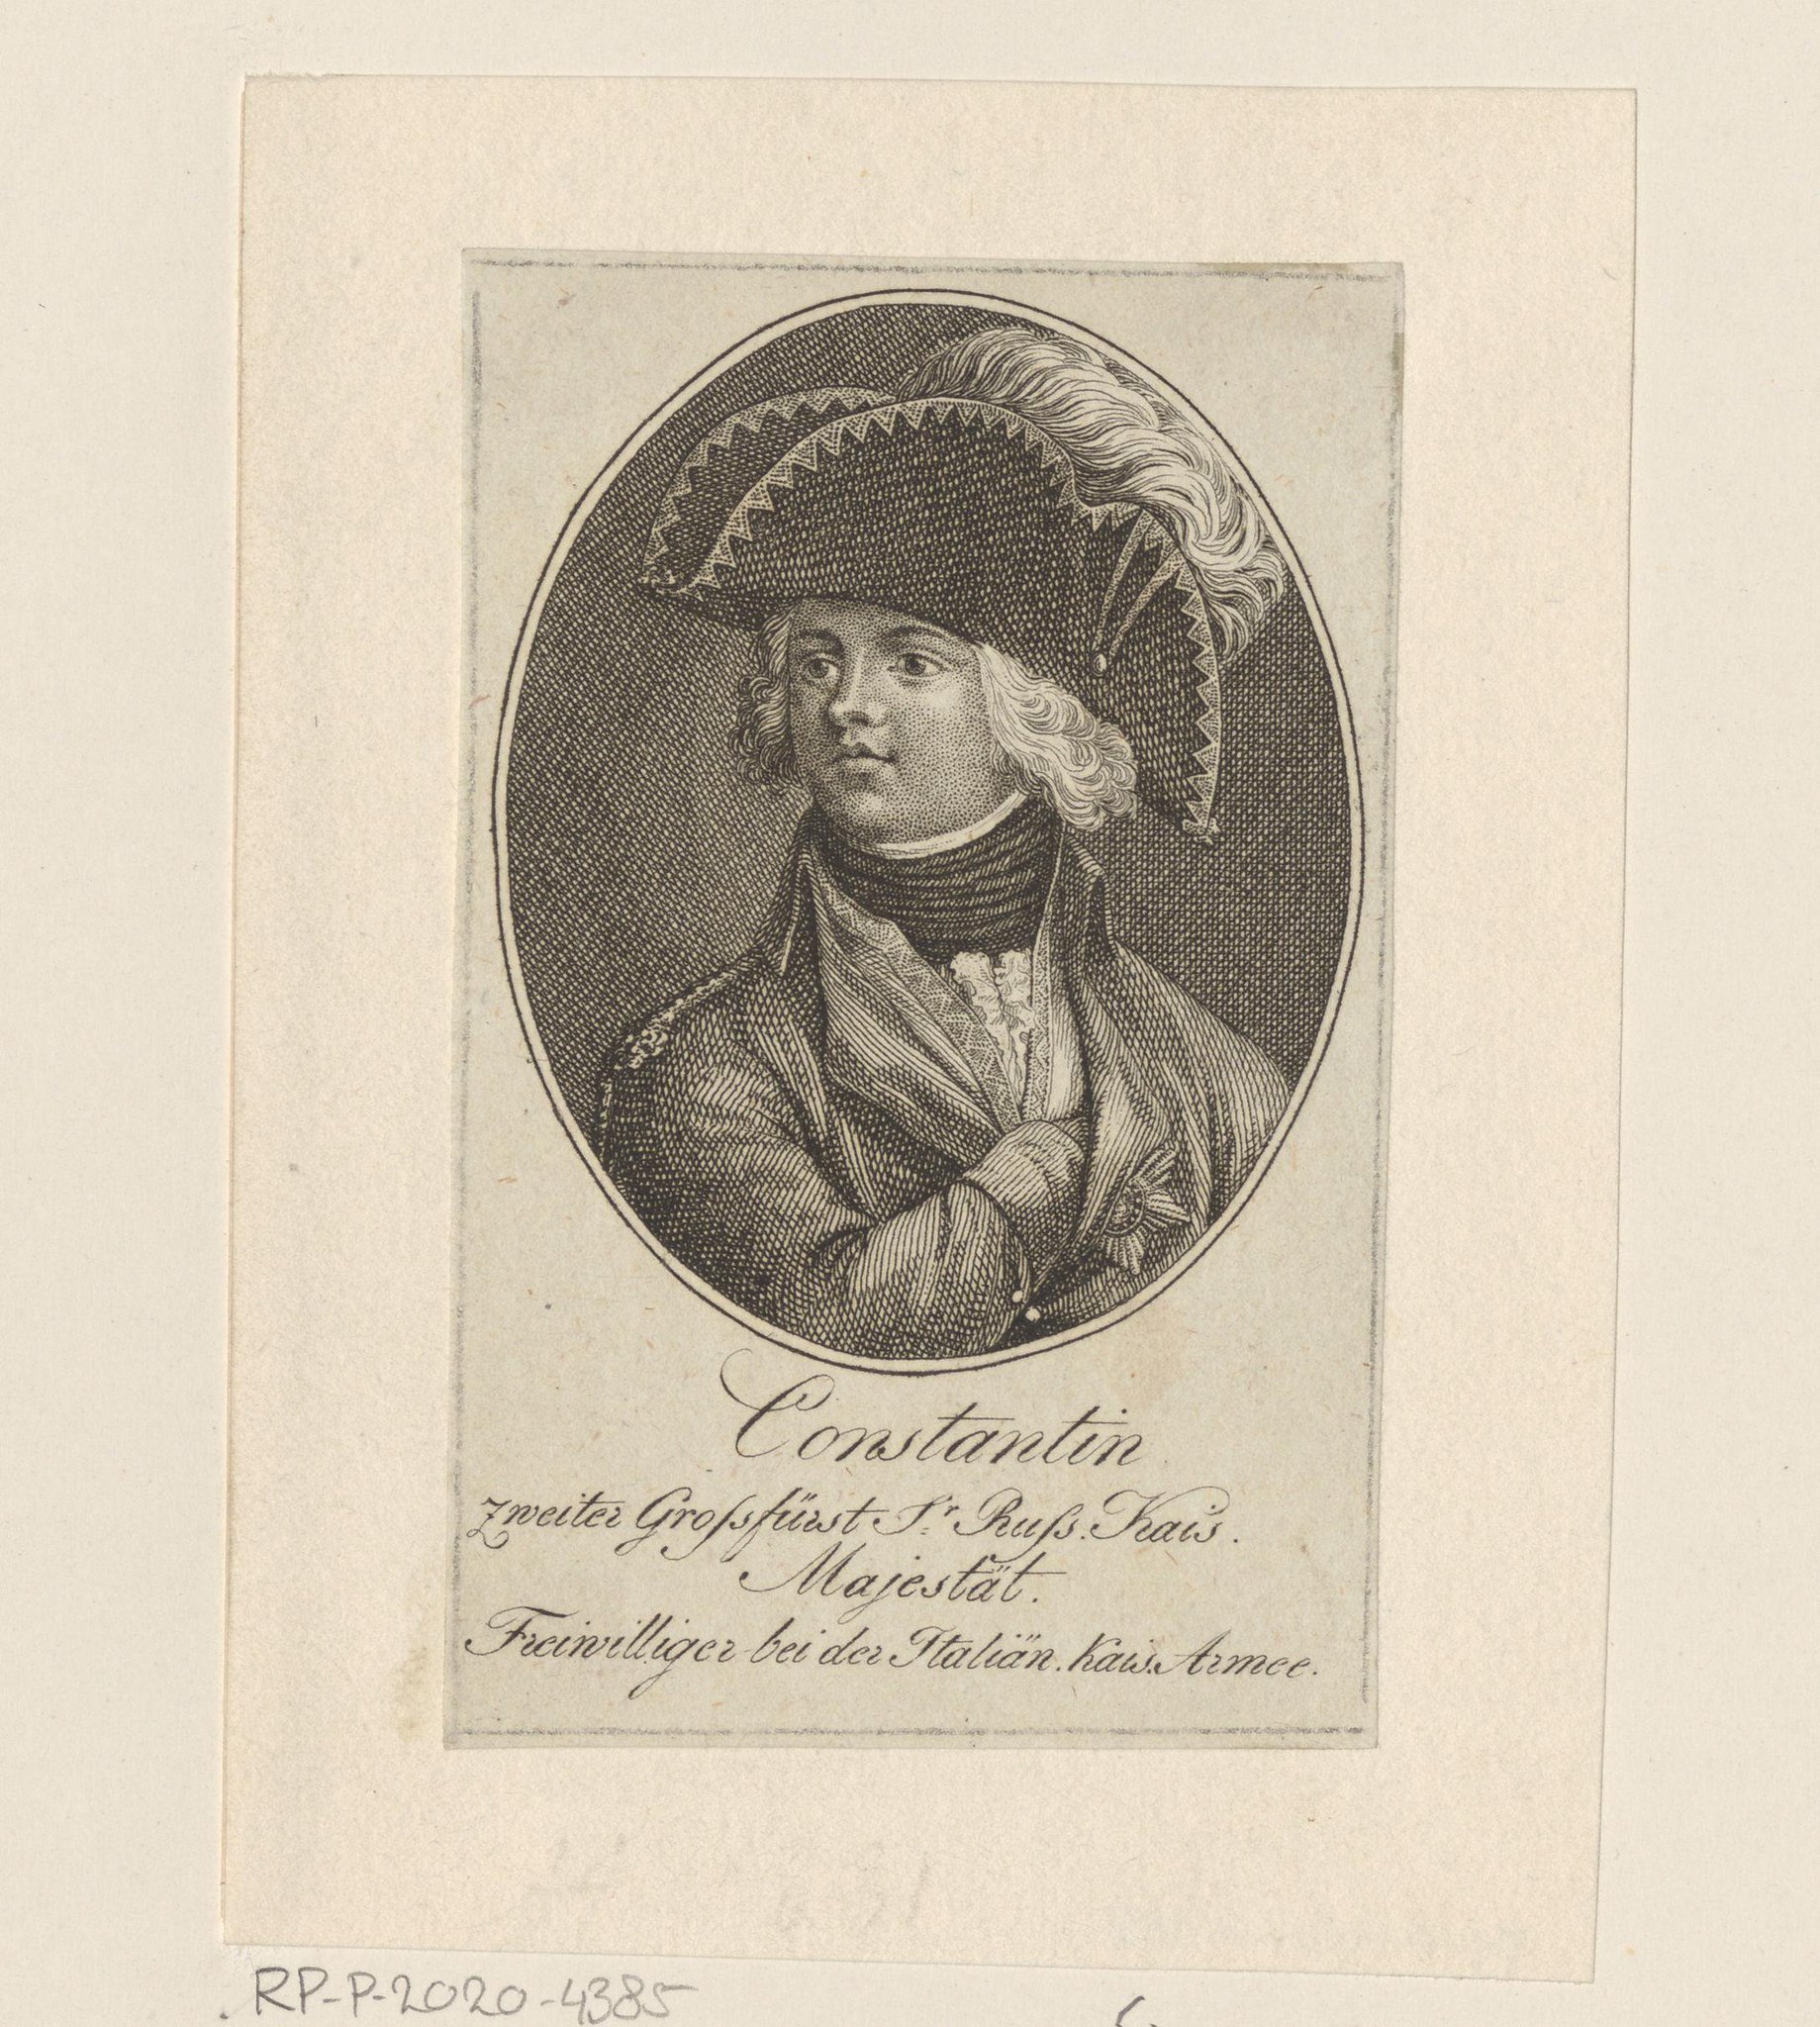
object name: print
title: Portret van Constantijn Pavlovitsj van Rusland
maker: Anonymous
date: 1800-1849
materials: paper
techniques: etching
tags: historical persons, ruler, sovereign